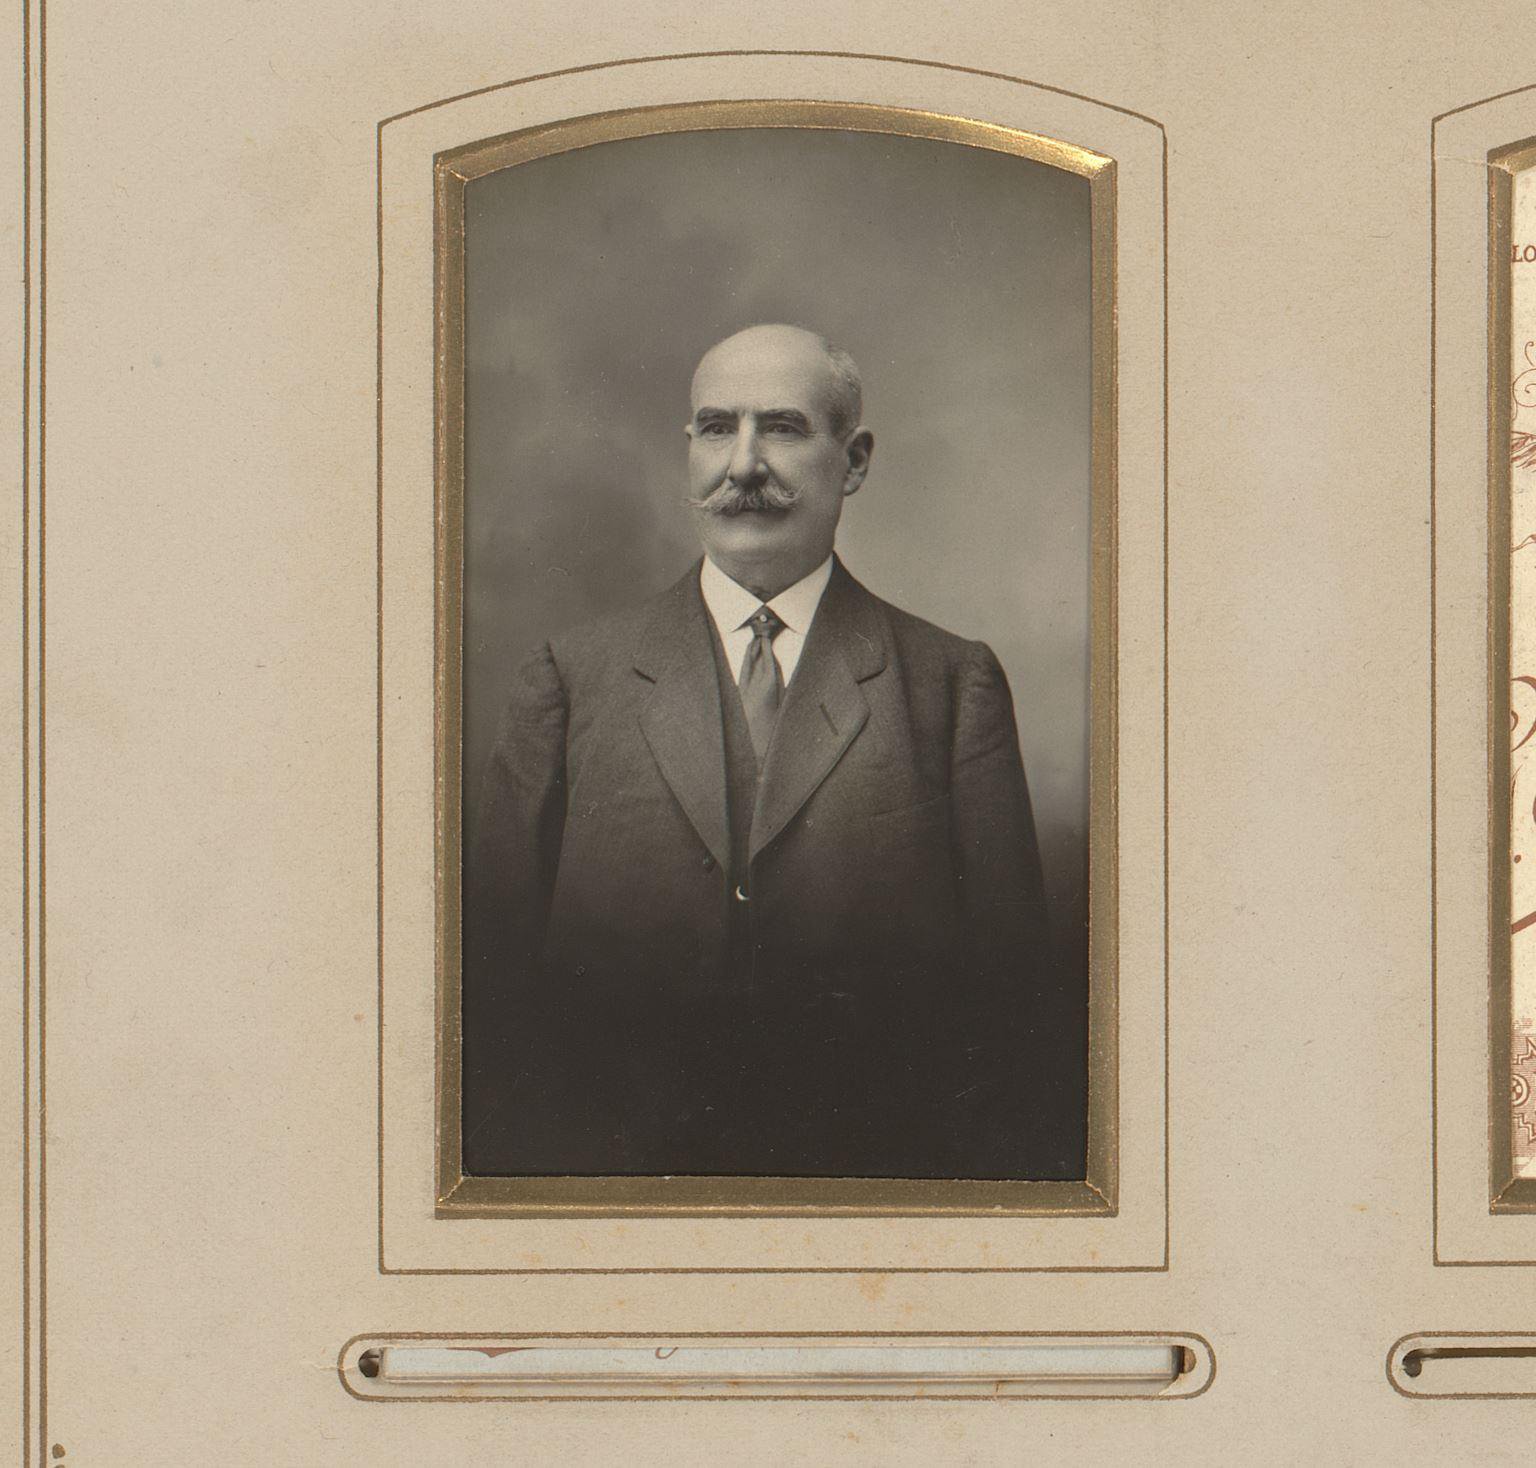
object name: carte de visite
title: Portret van een man met snor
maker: emile heury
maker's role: fotograaf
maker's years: 1863-1931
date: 1880-1930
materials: cardboard, photographic support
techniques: gelatin silver print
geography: lyon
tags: moustache, historical persons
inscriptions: inscription: ‘Photographie/ Général/ MÉDAILLE EN FRANCE/ & A L'ÉTRANGER/ E. Heury/ LYON/ 106/ Cours Lafayette/ Portraits Charbon/ Simili Gravure/ et en Couleurs/ AGRANDISSEMENTS REPRODUCTIONS/ les Clichés sont conservés’